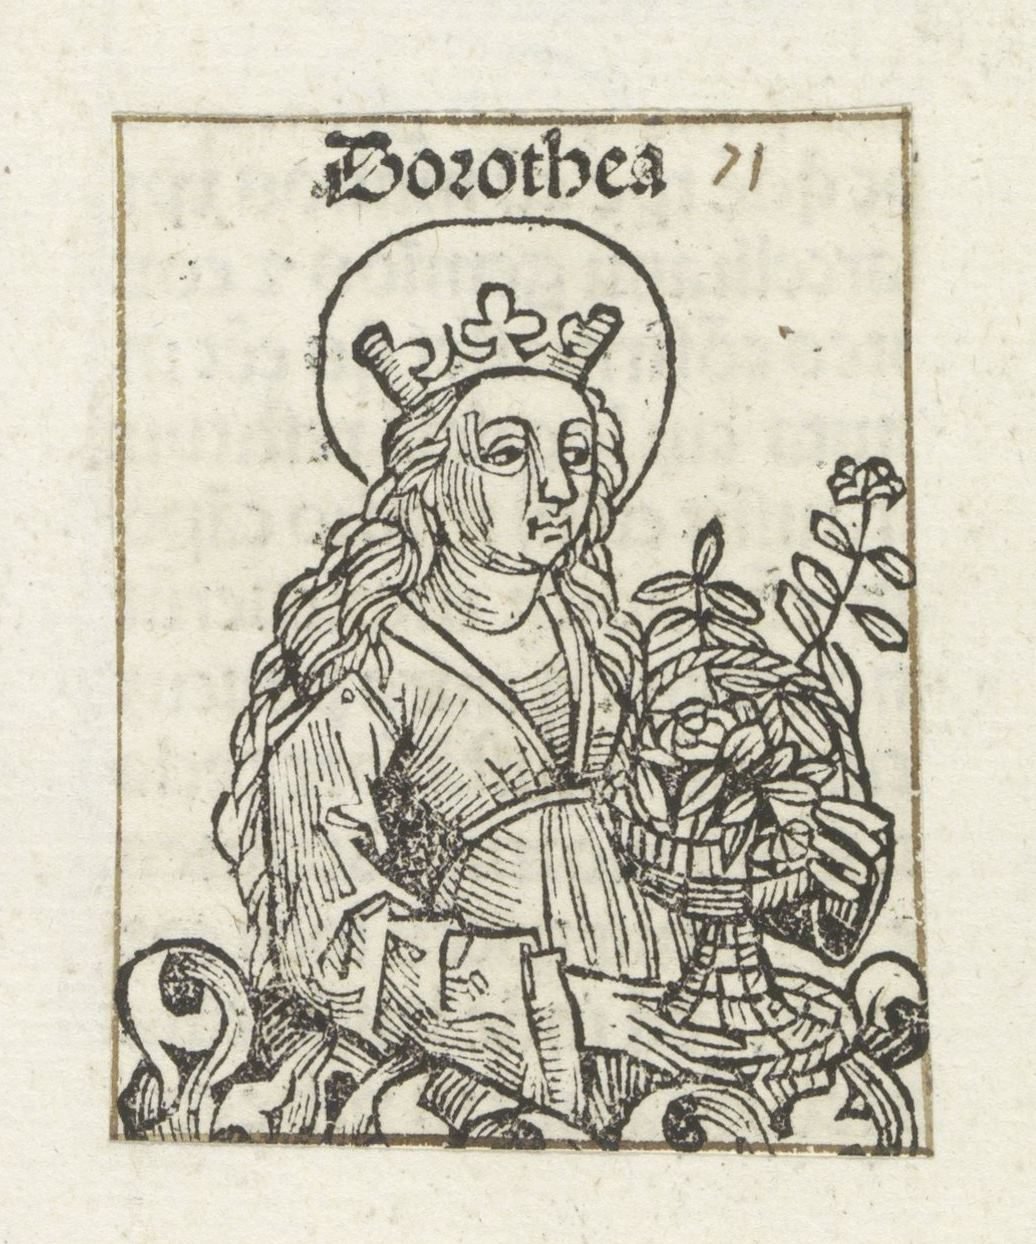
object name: album leaf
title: Liber Chronicarum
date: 1493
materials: paper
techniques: letterpress printing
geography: nuremberg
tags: the virgin martyr dorothea of caesarea; possible attributes: basket of roses and apples, child with basket of roses, garland of roses, roses in hand or lap, martyr(s) (often with palm-branches)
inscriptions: inscription: ‘71’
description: Een bloemkelk met een heilige vrouw, te herkennen aan de nimbus om haar hoofd. In haar handen heeft ze een mand met fruit en bloemen. De tekst identificeert haar als de heilige Dorothea. De prent maakt deel uit van een album.